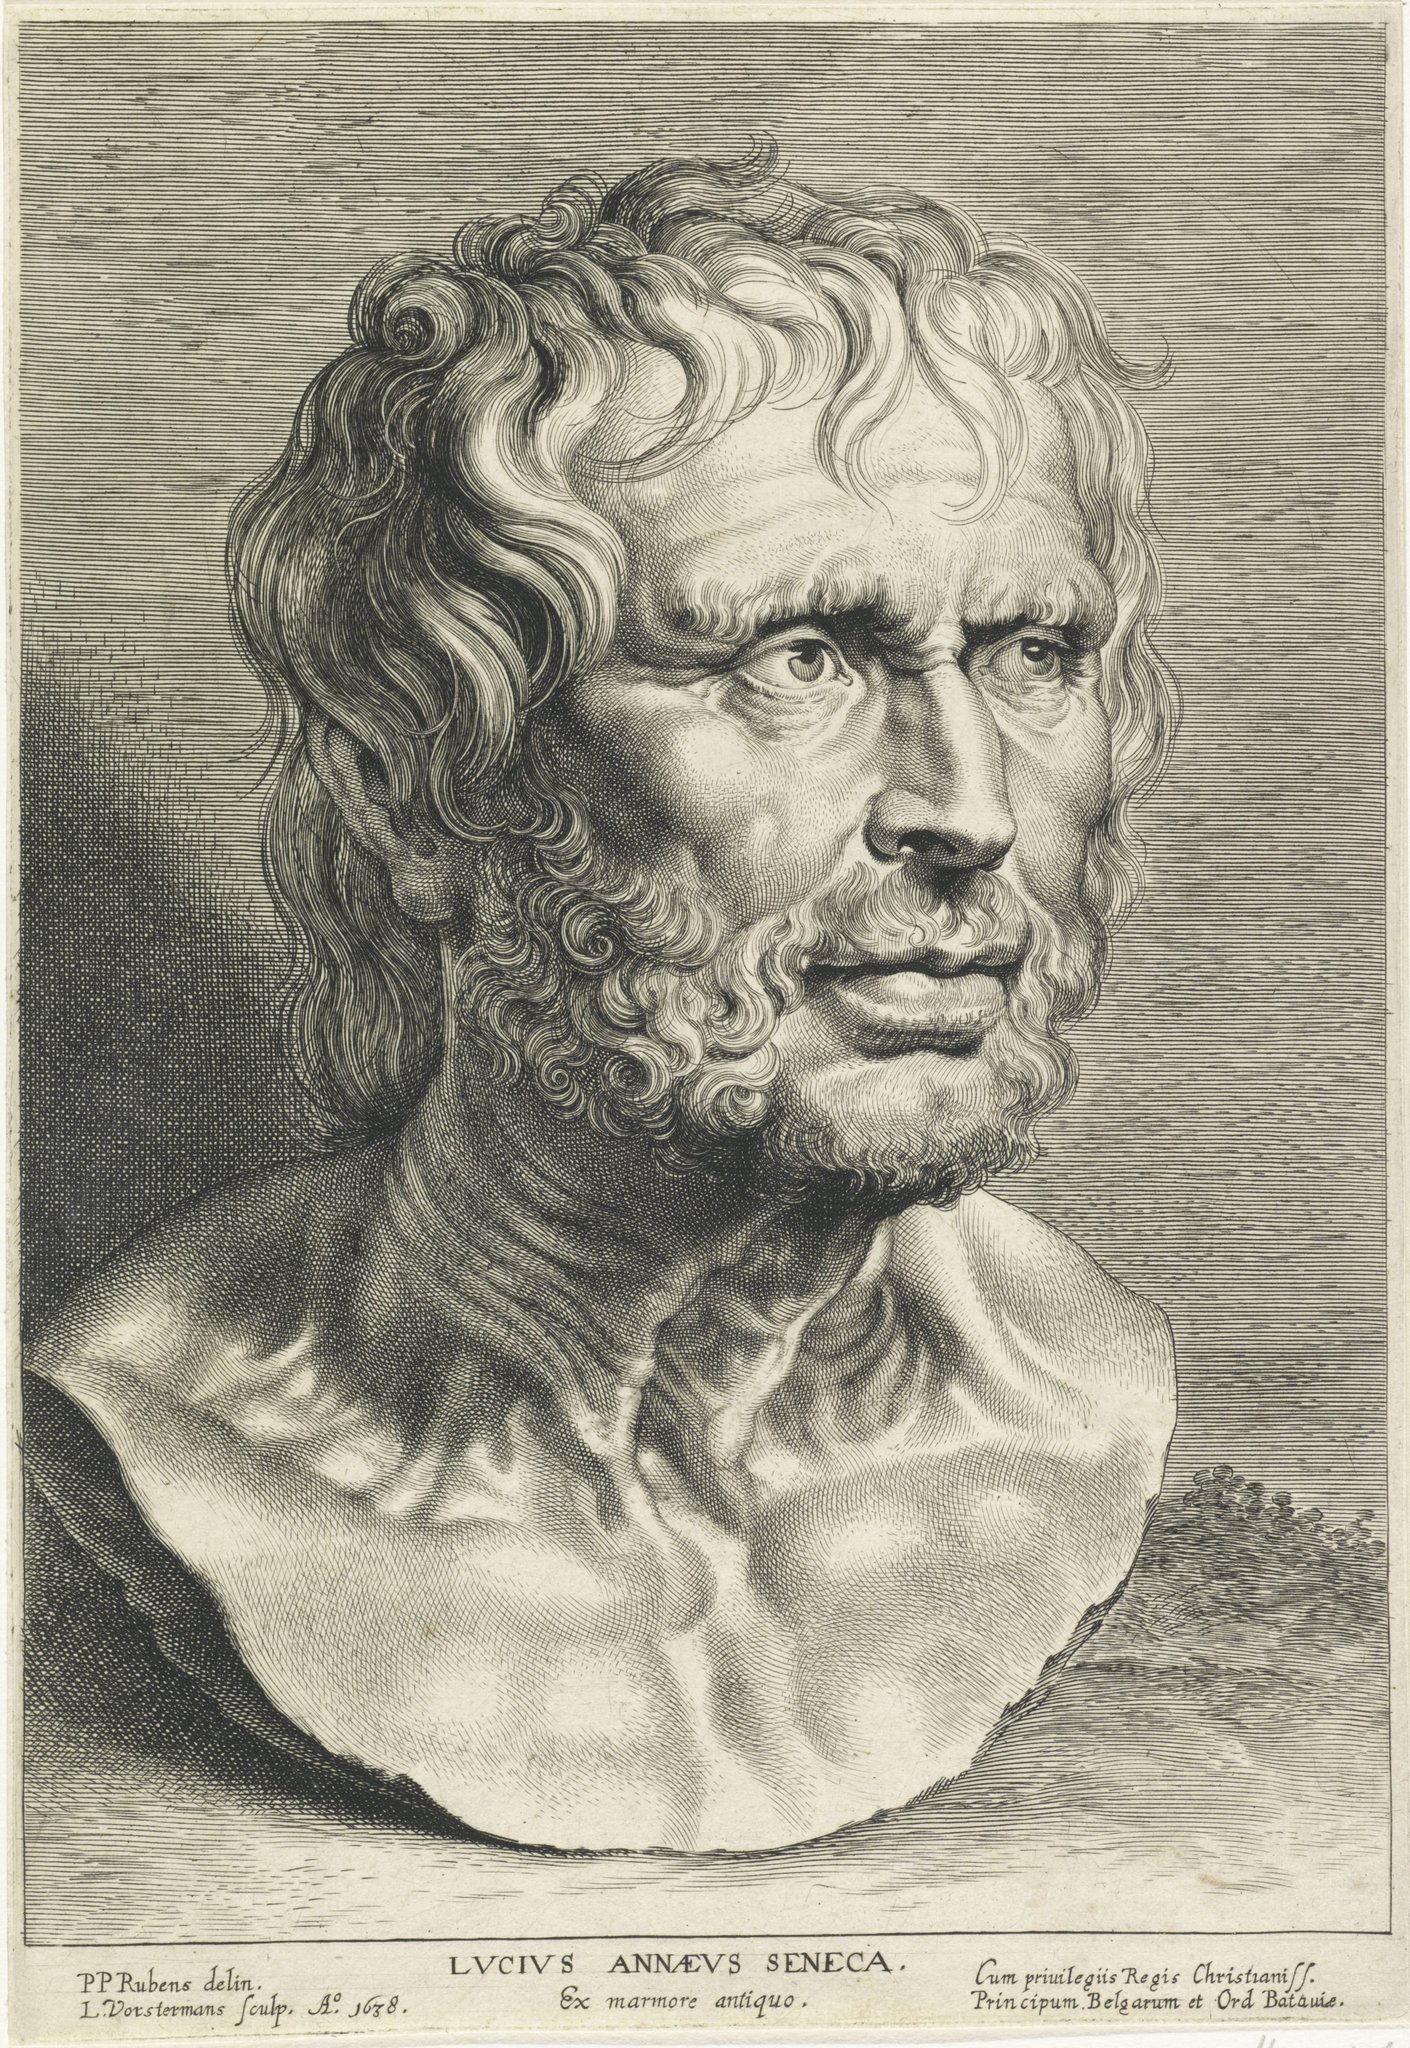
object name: print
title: Buste van Seneca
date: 1638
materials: paper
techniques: engraving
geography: antwerp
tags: piece of sculpture, reproduction of a piece of sculpture, (story of) seneca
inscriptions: collector's mark: Lugt 240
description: Buste van Seneca. Prent uit een serie van twaalf prenten met antieke bustes, waarvan vier door Lucas Vorsterman I en acht door Boëtius Adamsz. Bolswert.